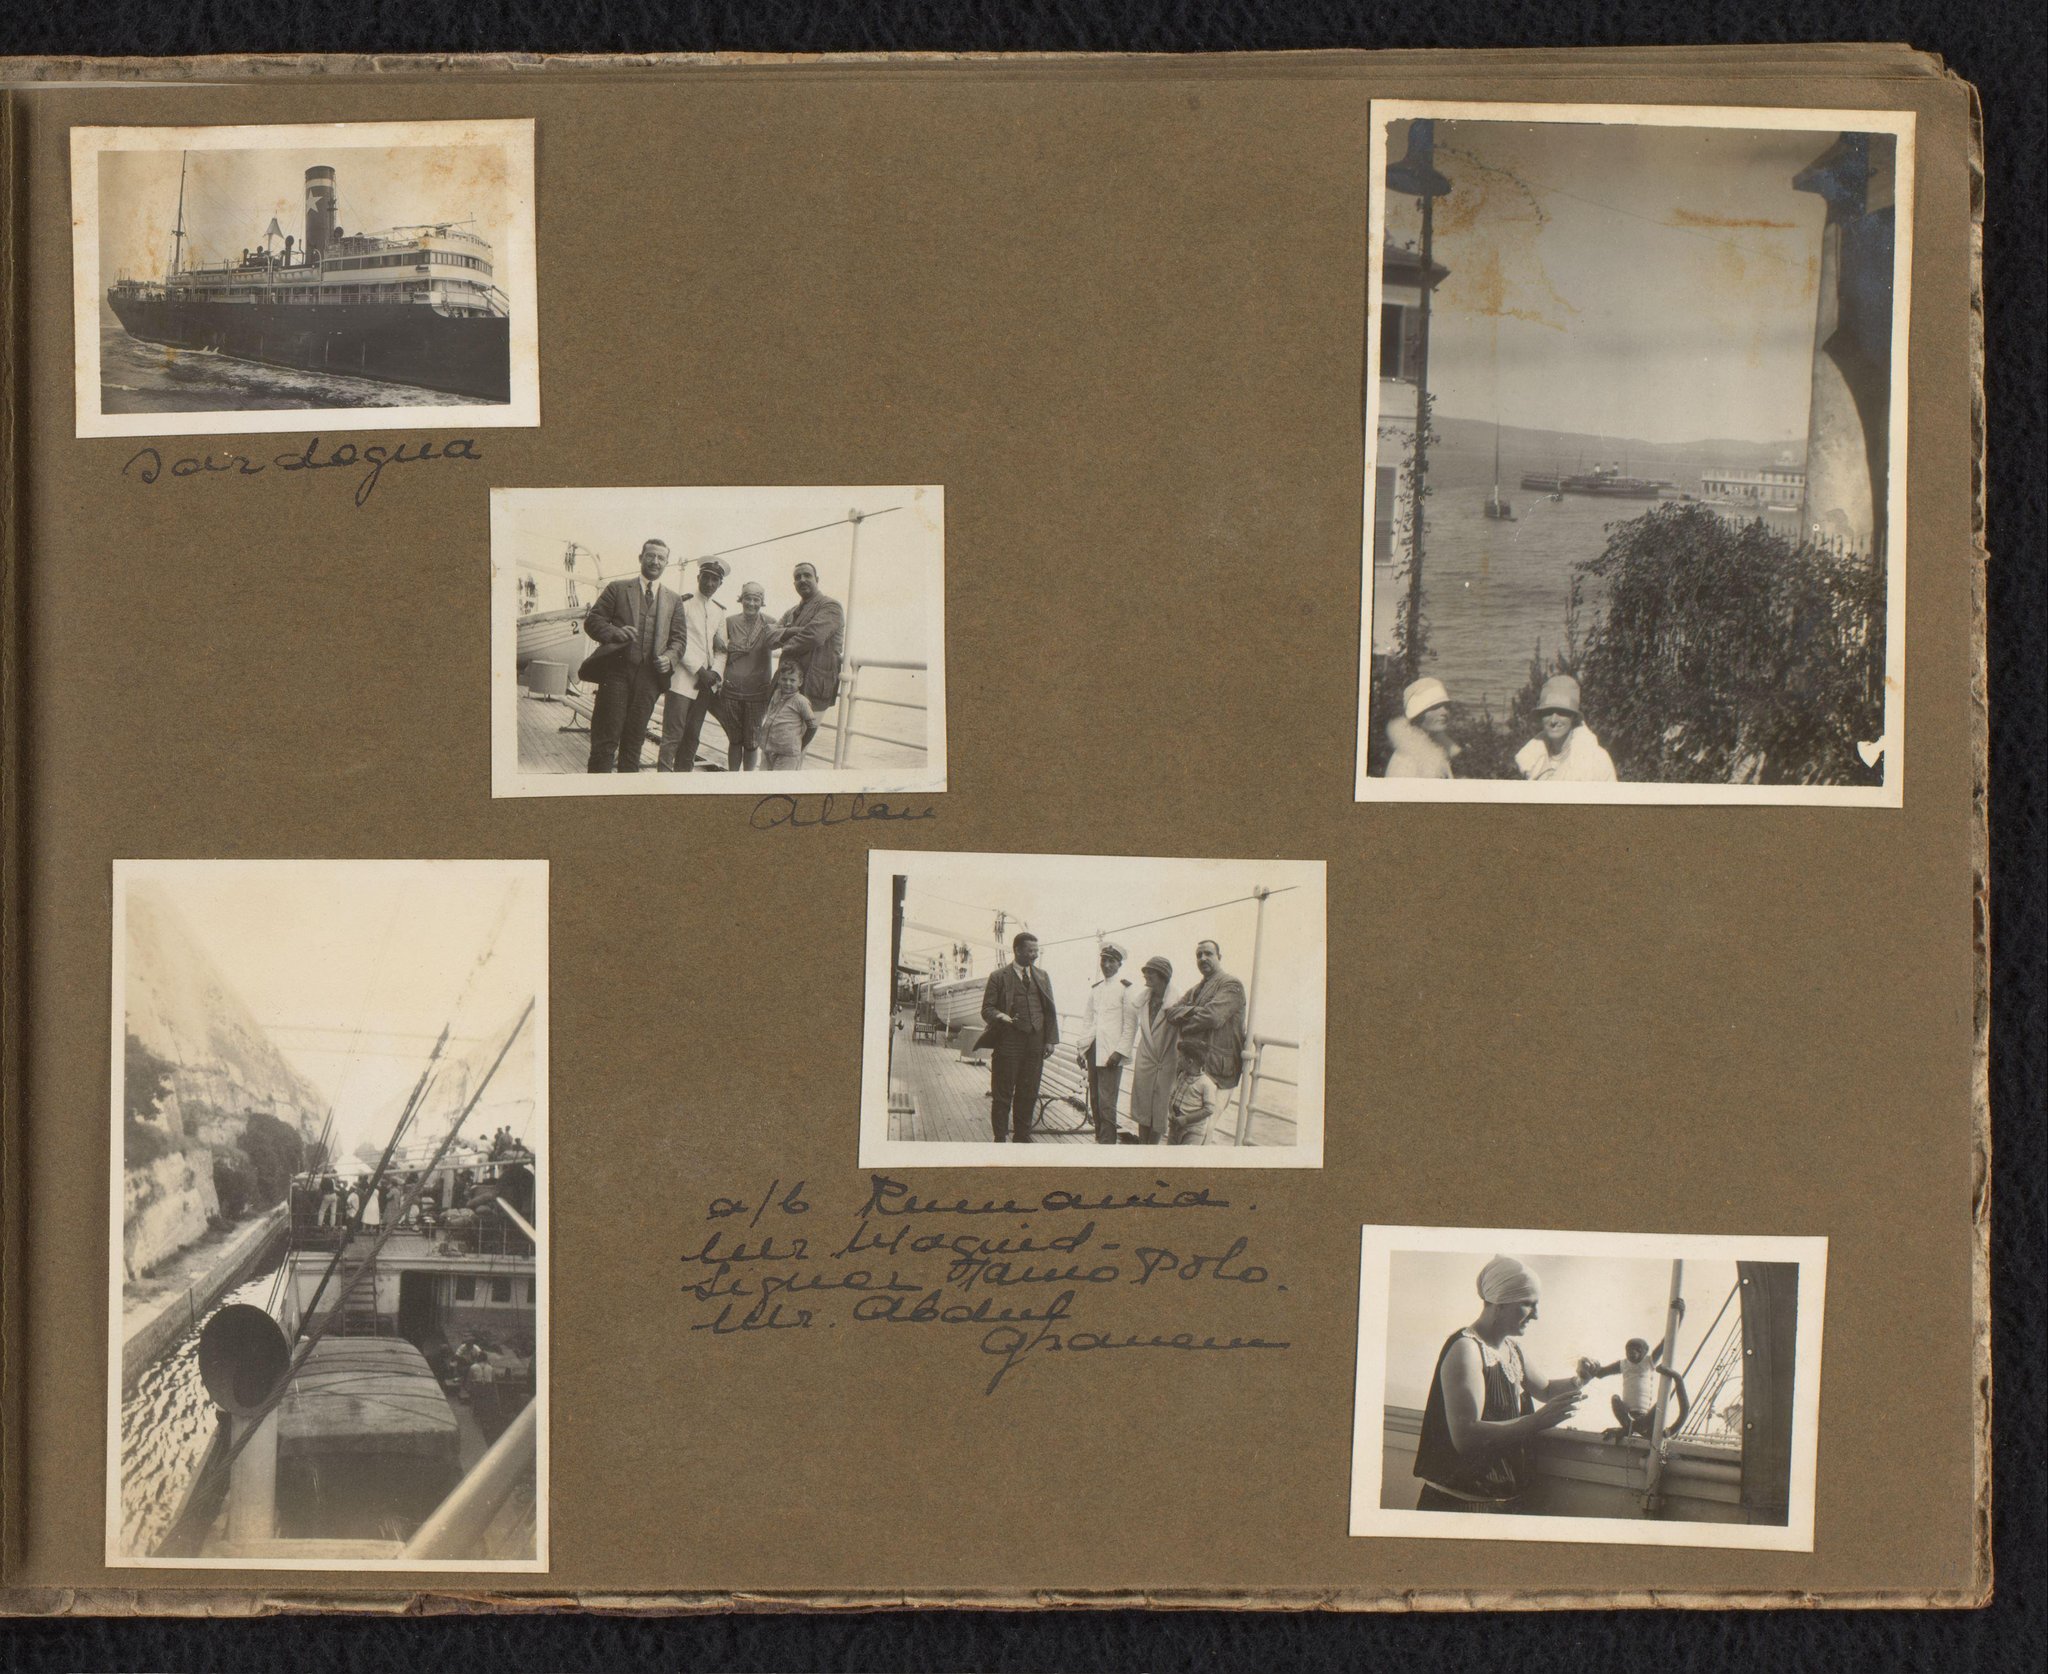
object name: photograph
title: Zes foto's van de schepen Sardegna en Rumania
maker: carolina frederika onnen (lien/loen)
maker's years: 1896-1983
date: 1909-1926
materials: paper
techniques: gelatin silver print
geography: mediterranean sea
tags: monkeys, apes, canal, crew and passengers ~ ship, steamship, motorship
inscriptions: inscription: ‘a/b Rumania/ met Magied/ Signor Tamo Polo/ Mr. Abdul/ Ghanam’, inscription: ‘Sardegna’, inscription: ‘Allen’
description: Deze foto's maken deel uit van een album.